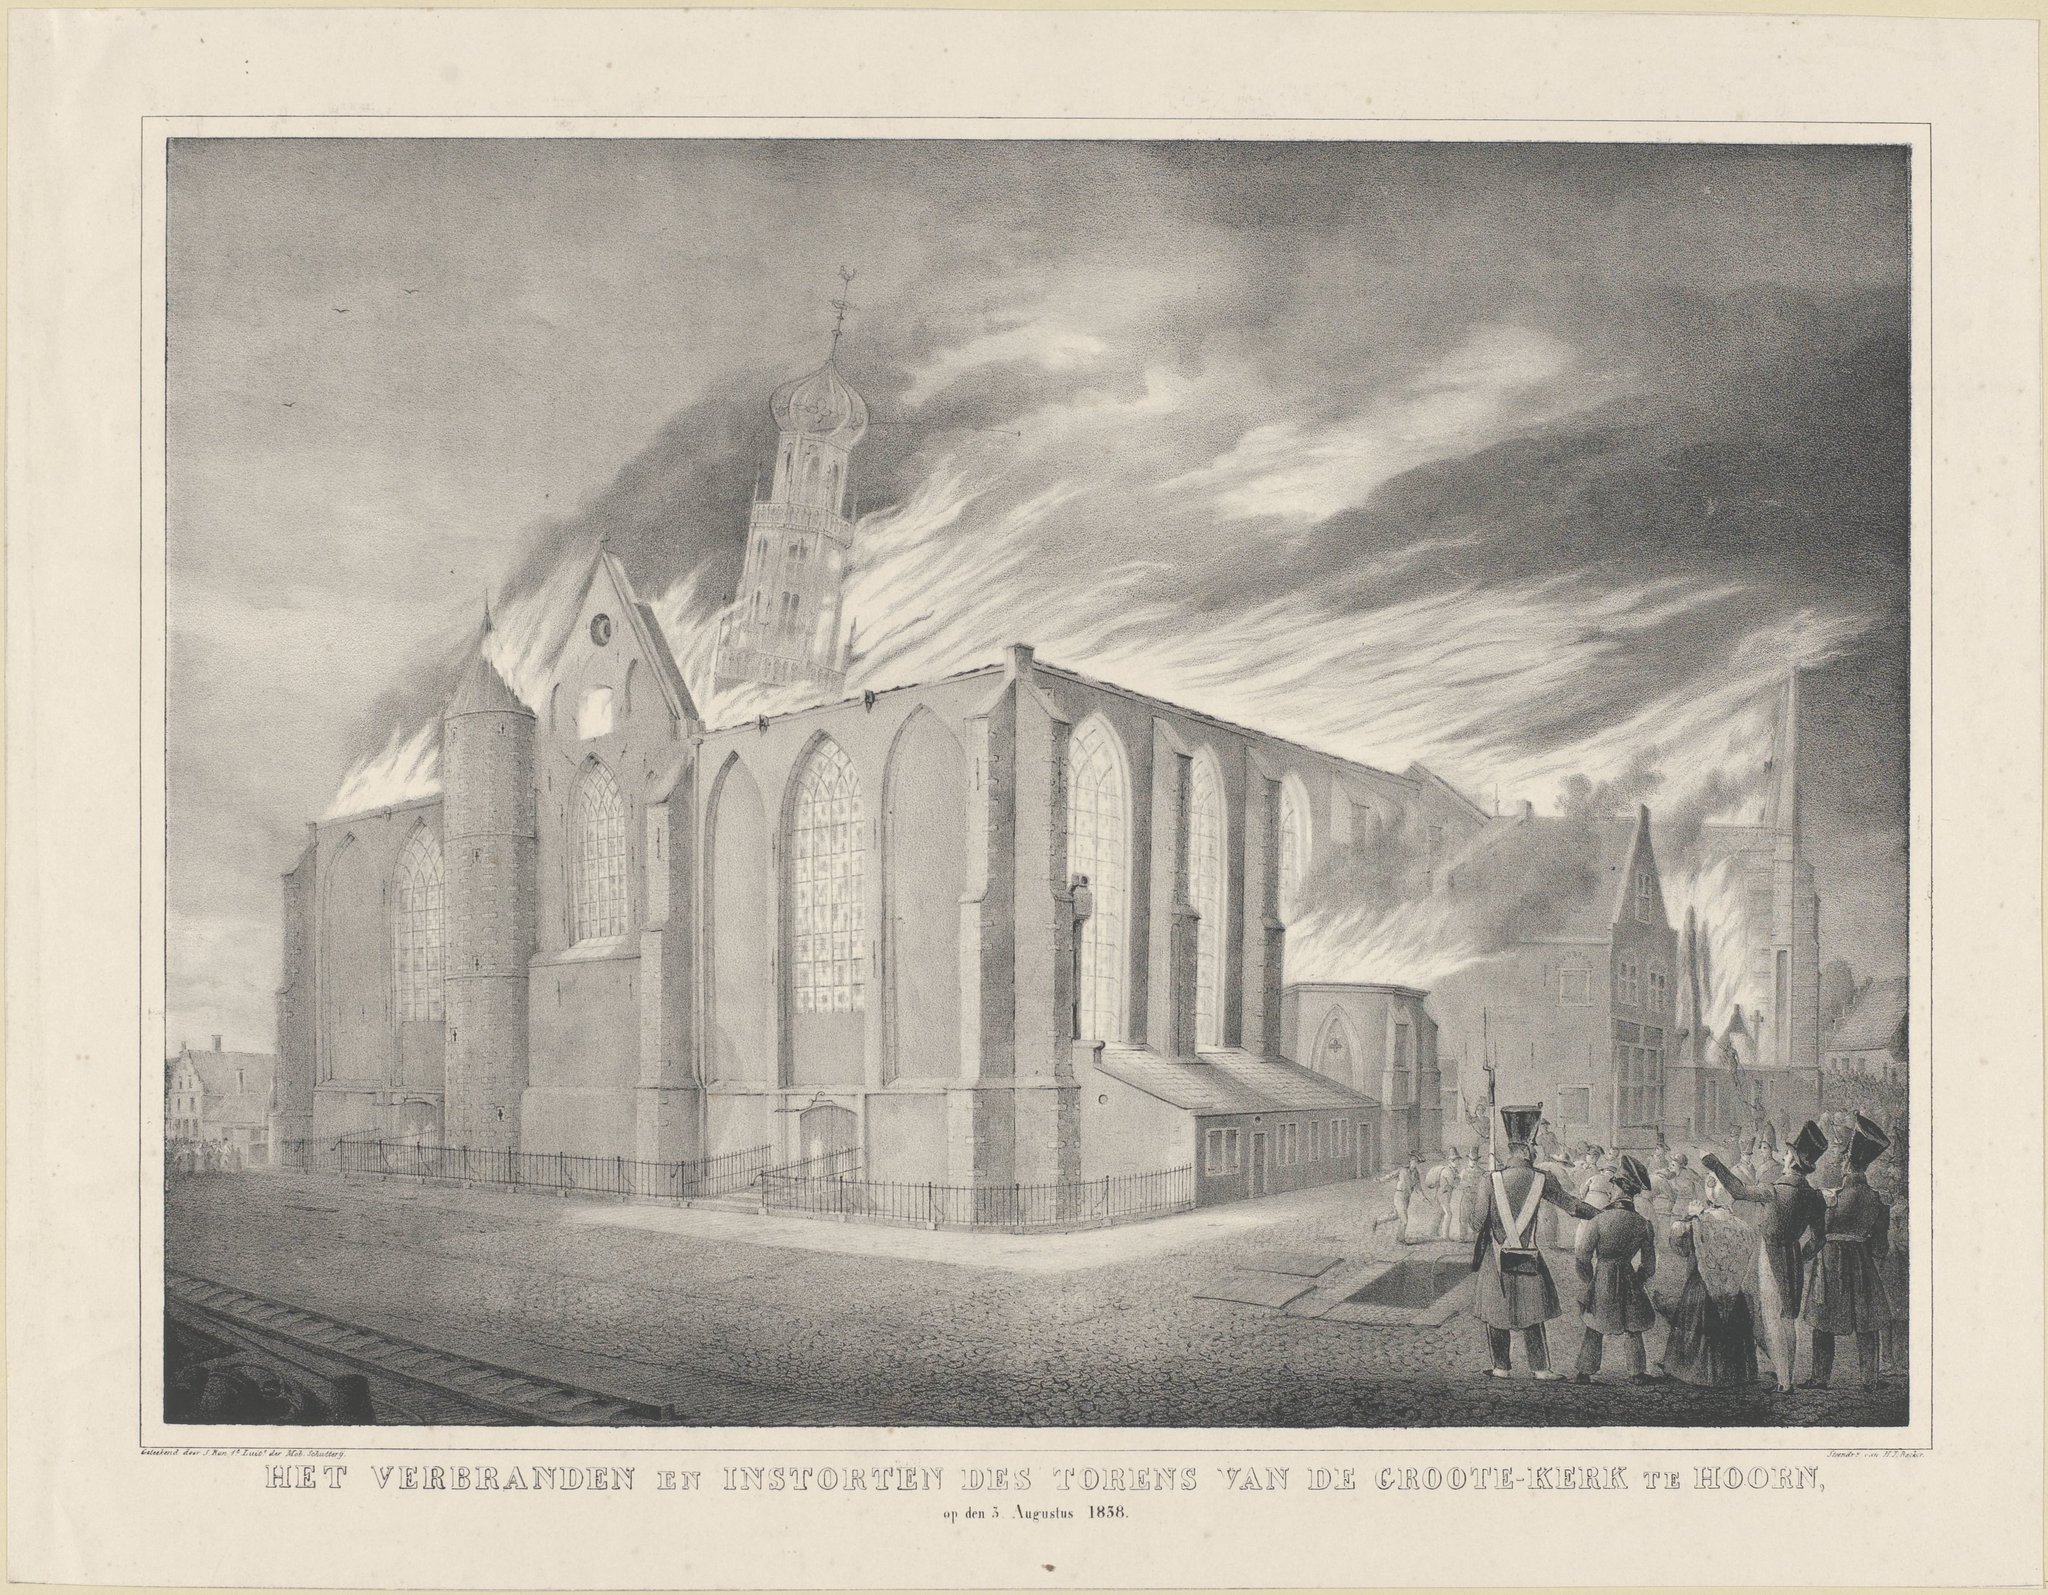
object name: print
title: Het verbranden en instorten des torens van de Groote-Kerk te Hoorn, op den 3. Augustus 1838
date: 1838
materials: paper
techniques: lithograph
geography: netherlands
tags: on fire, ablaze, church (exterior), hoorn (north holland)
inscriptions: collector's mark: Lugt 2228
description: Uitslaande brand in de Grote Kerk te Hoorn op 3 augustus 1838, op het moment dat de kerk instort. Rechts houdt een schutter het publiek op afstand.